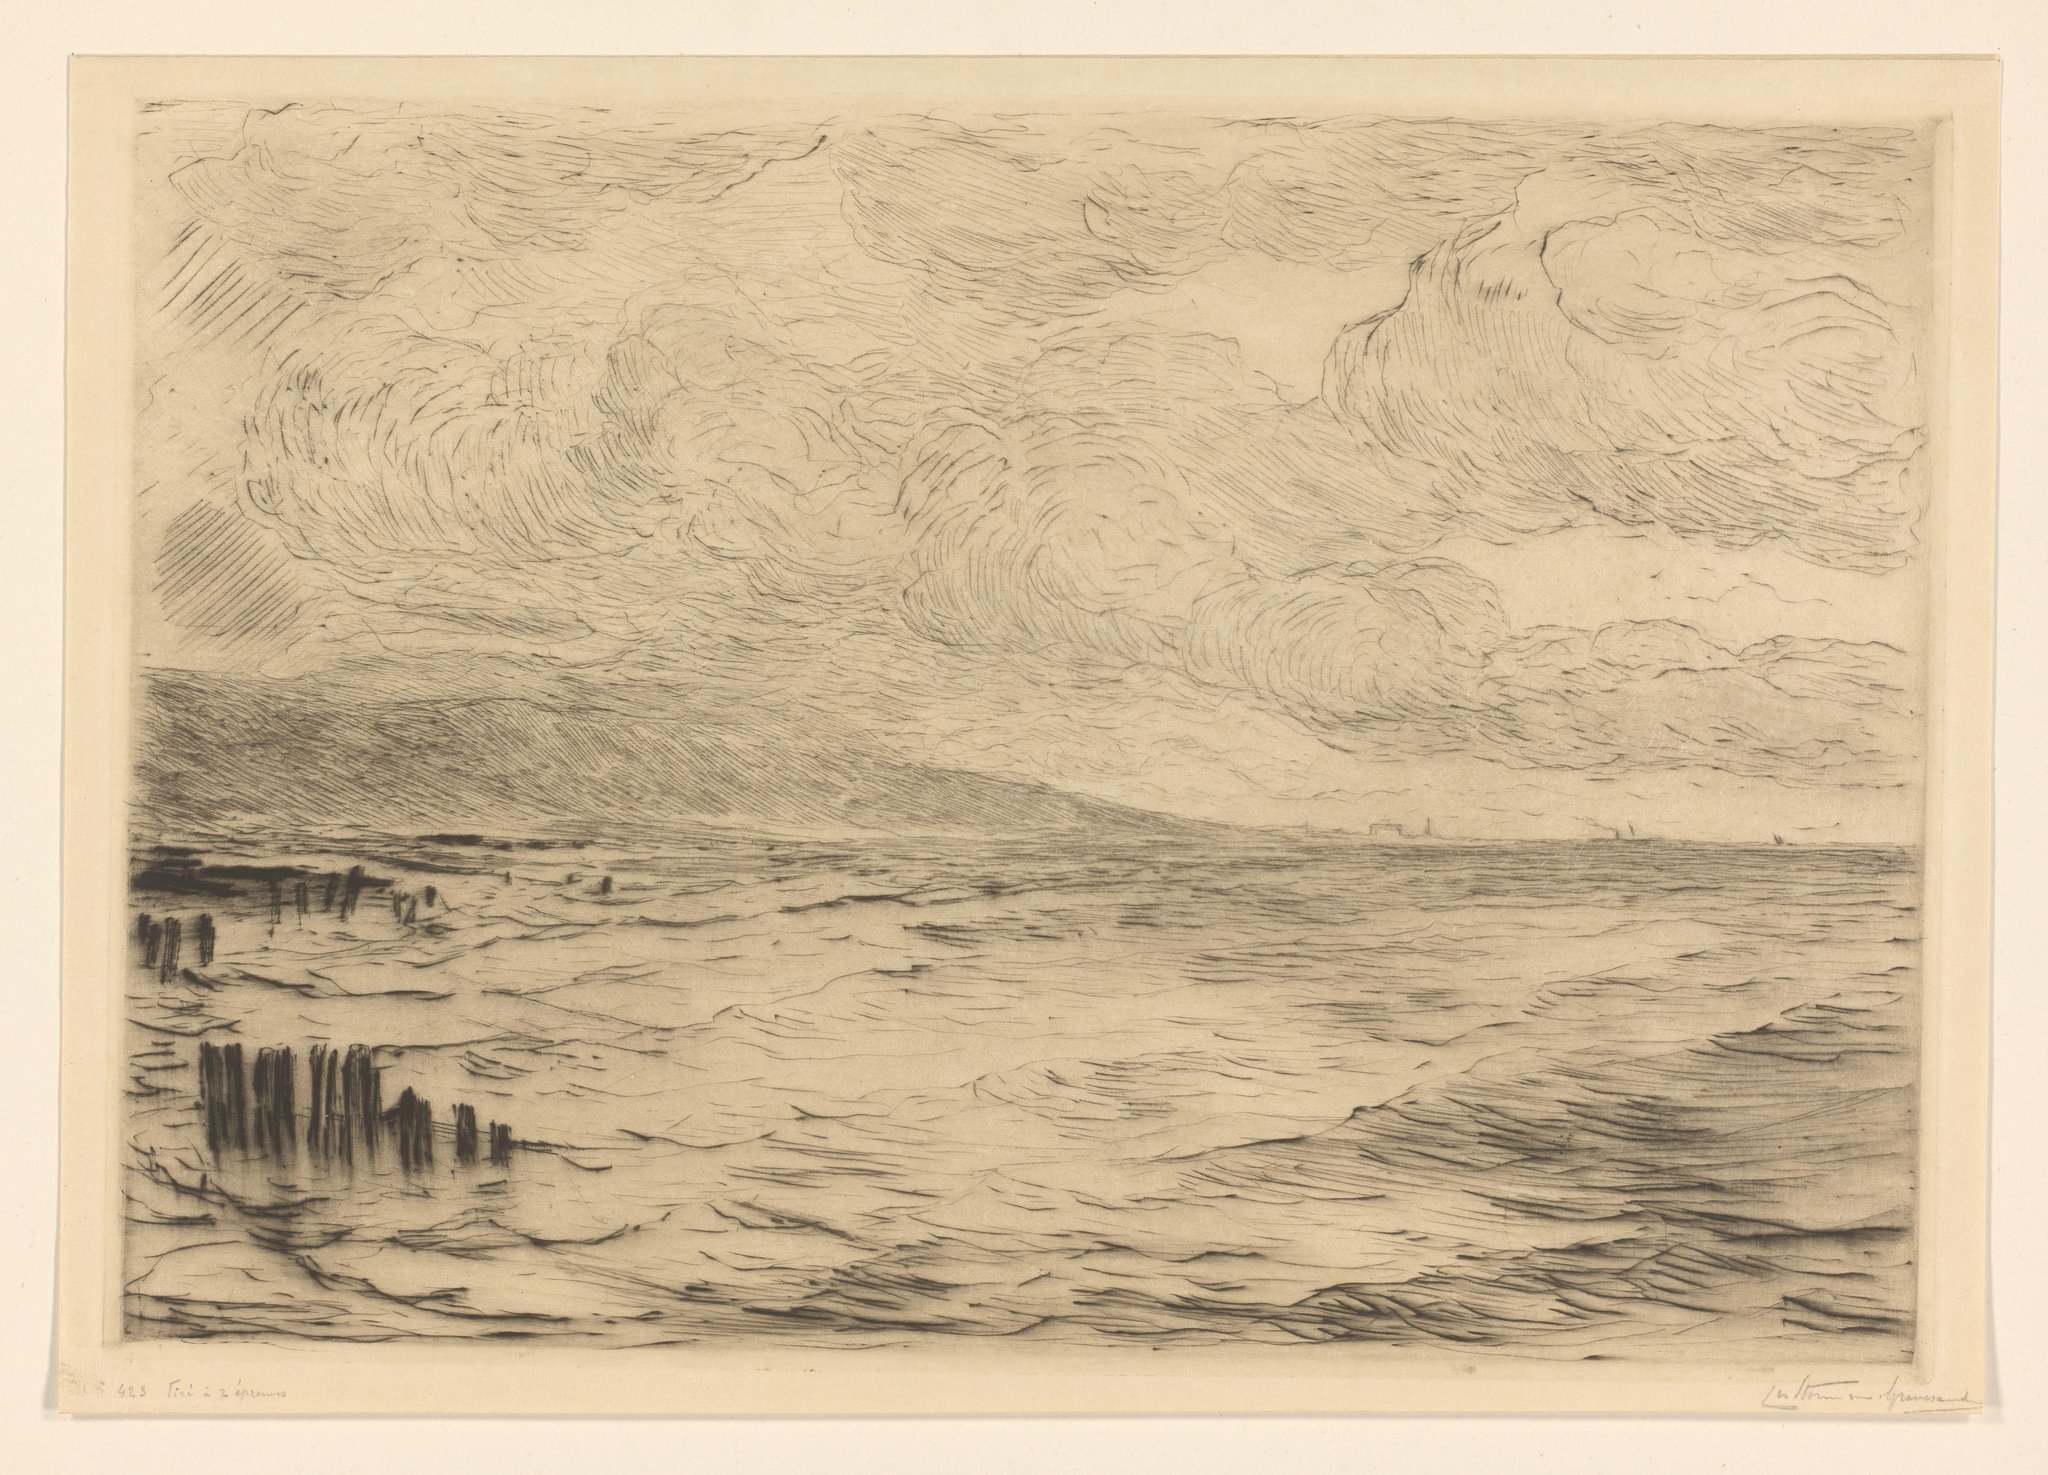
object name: print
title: De kust van Walcheren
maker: carel nicolaas storm van s-gravesande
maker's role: draughtsman, print maker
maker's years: 1841-1924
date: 1851-1902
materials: paper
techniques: drypoint, intaglio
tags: dune coast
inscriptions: collector's mark: Lugt 2228, annotation: ‘Tiré à 2 épreuves’